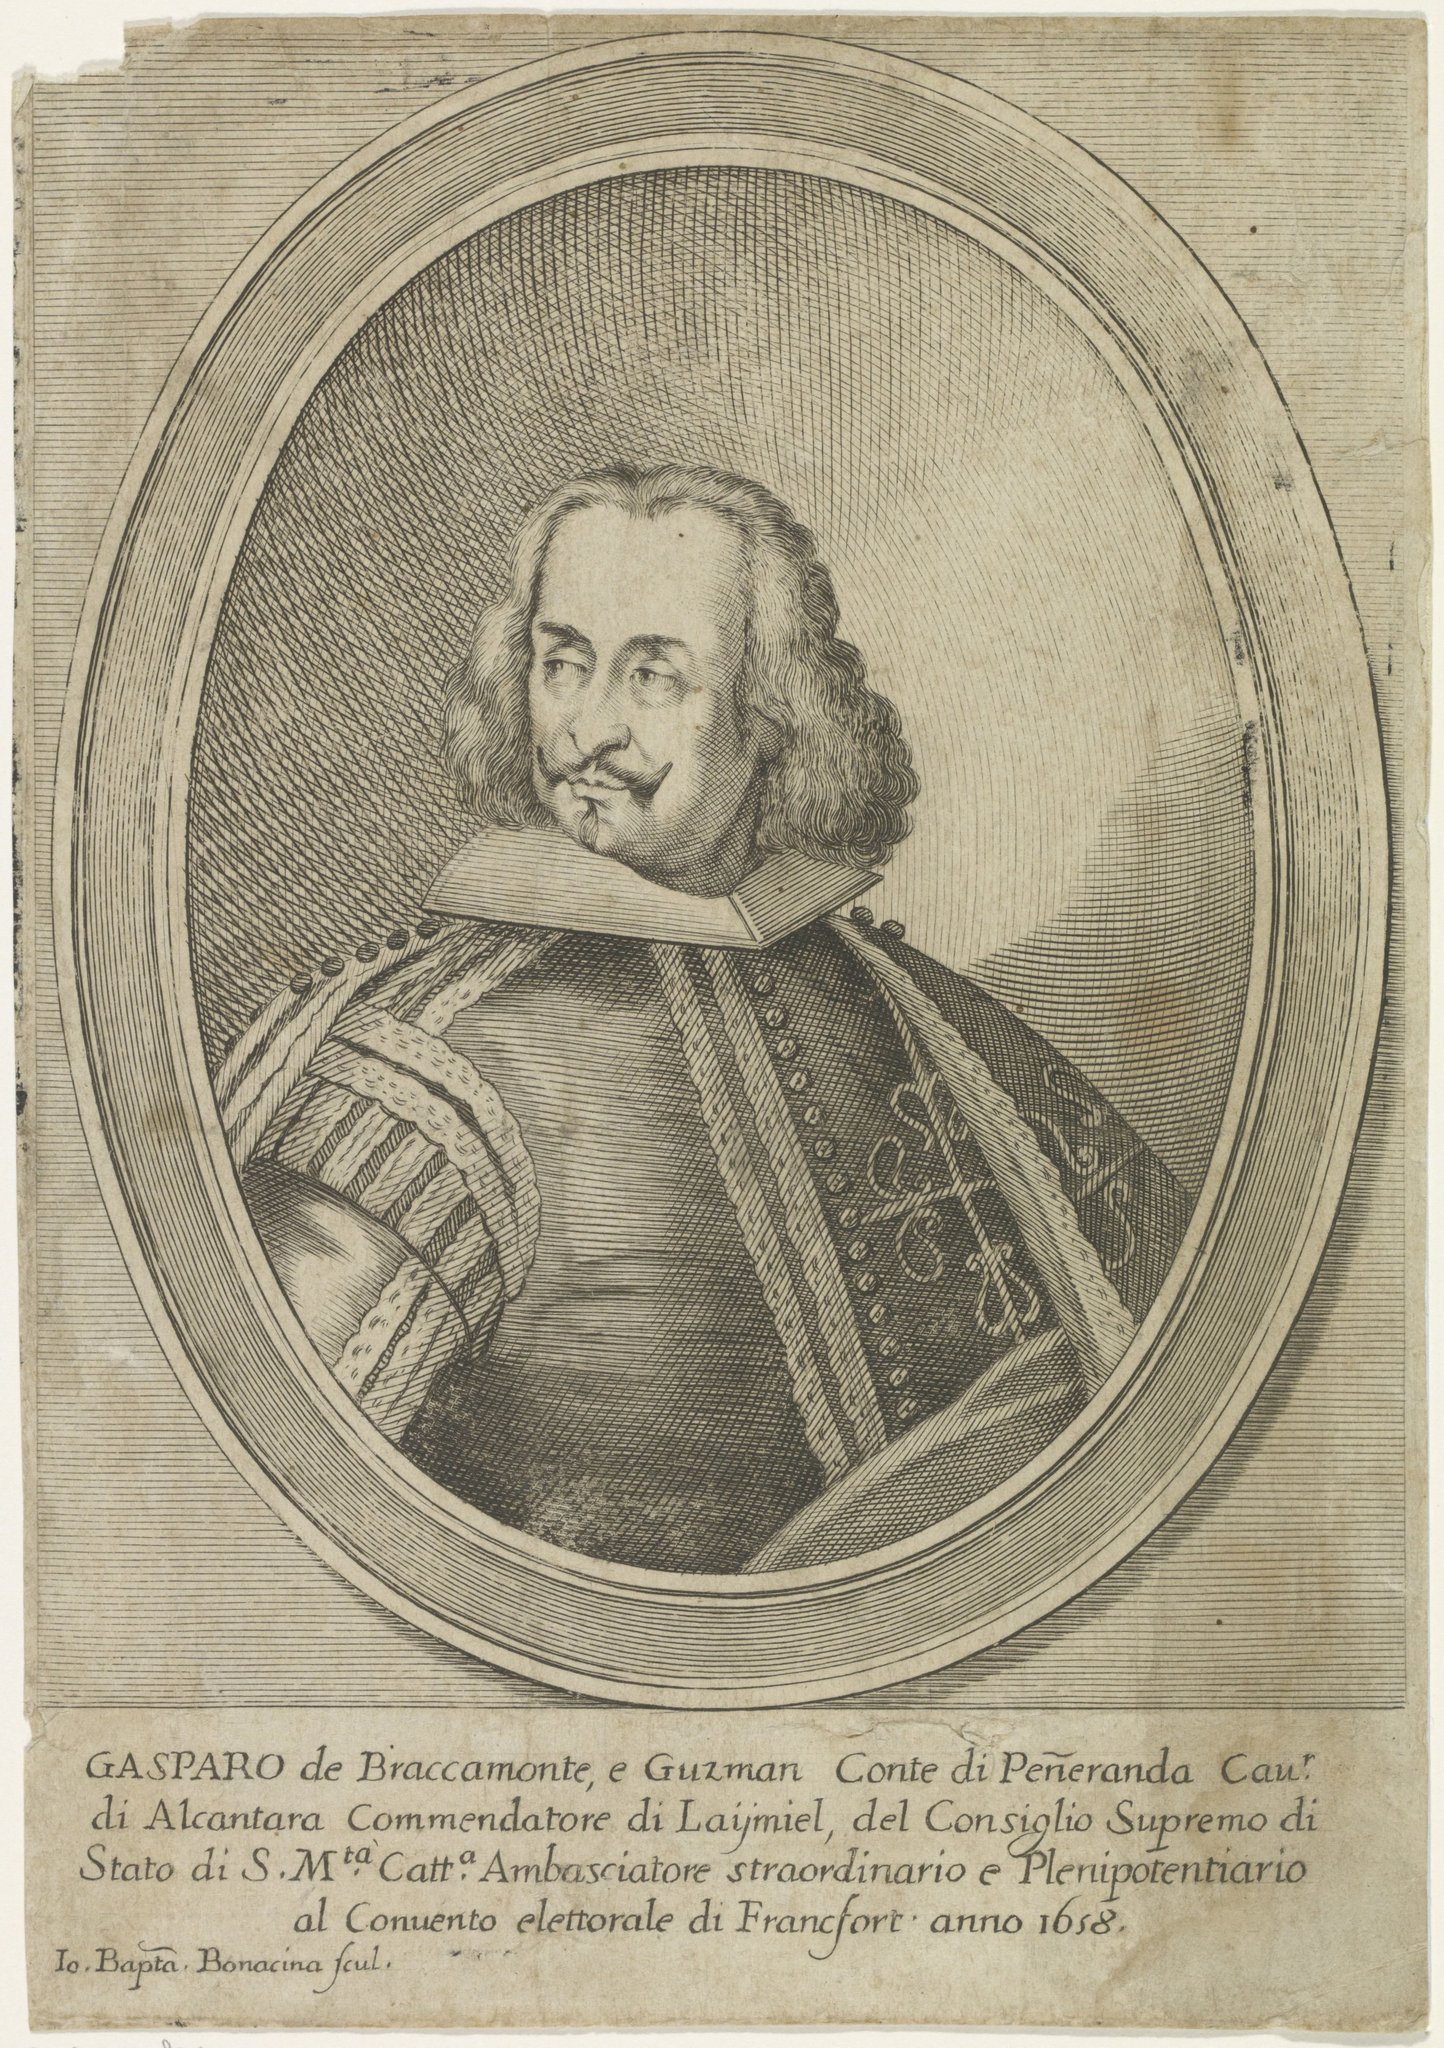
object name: print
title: Portret van Gaspar de Guzmán y Pimentel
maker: giovanni battista bonacina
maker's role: print maker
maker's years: 1615-1669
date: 1658-1669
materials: paper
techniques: engraving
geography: italy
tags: rome, historical persons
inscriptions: collector's mark: Lugt 2760, collector's mark: Lugt 2228